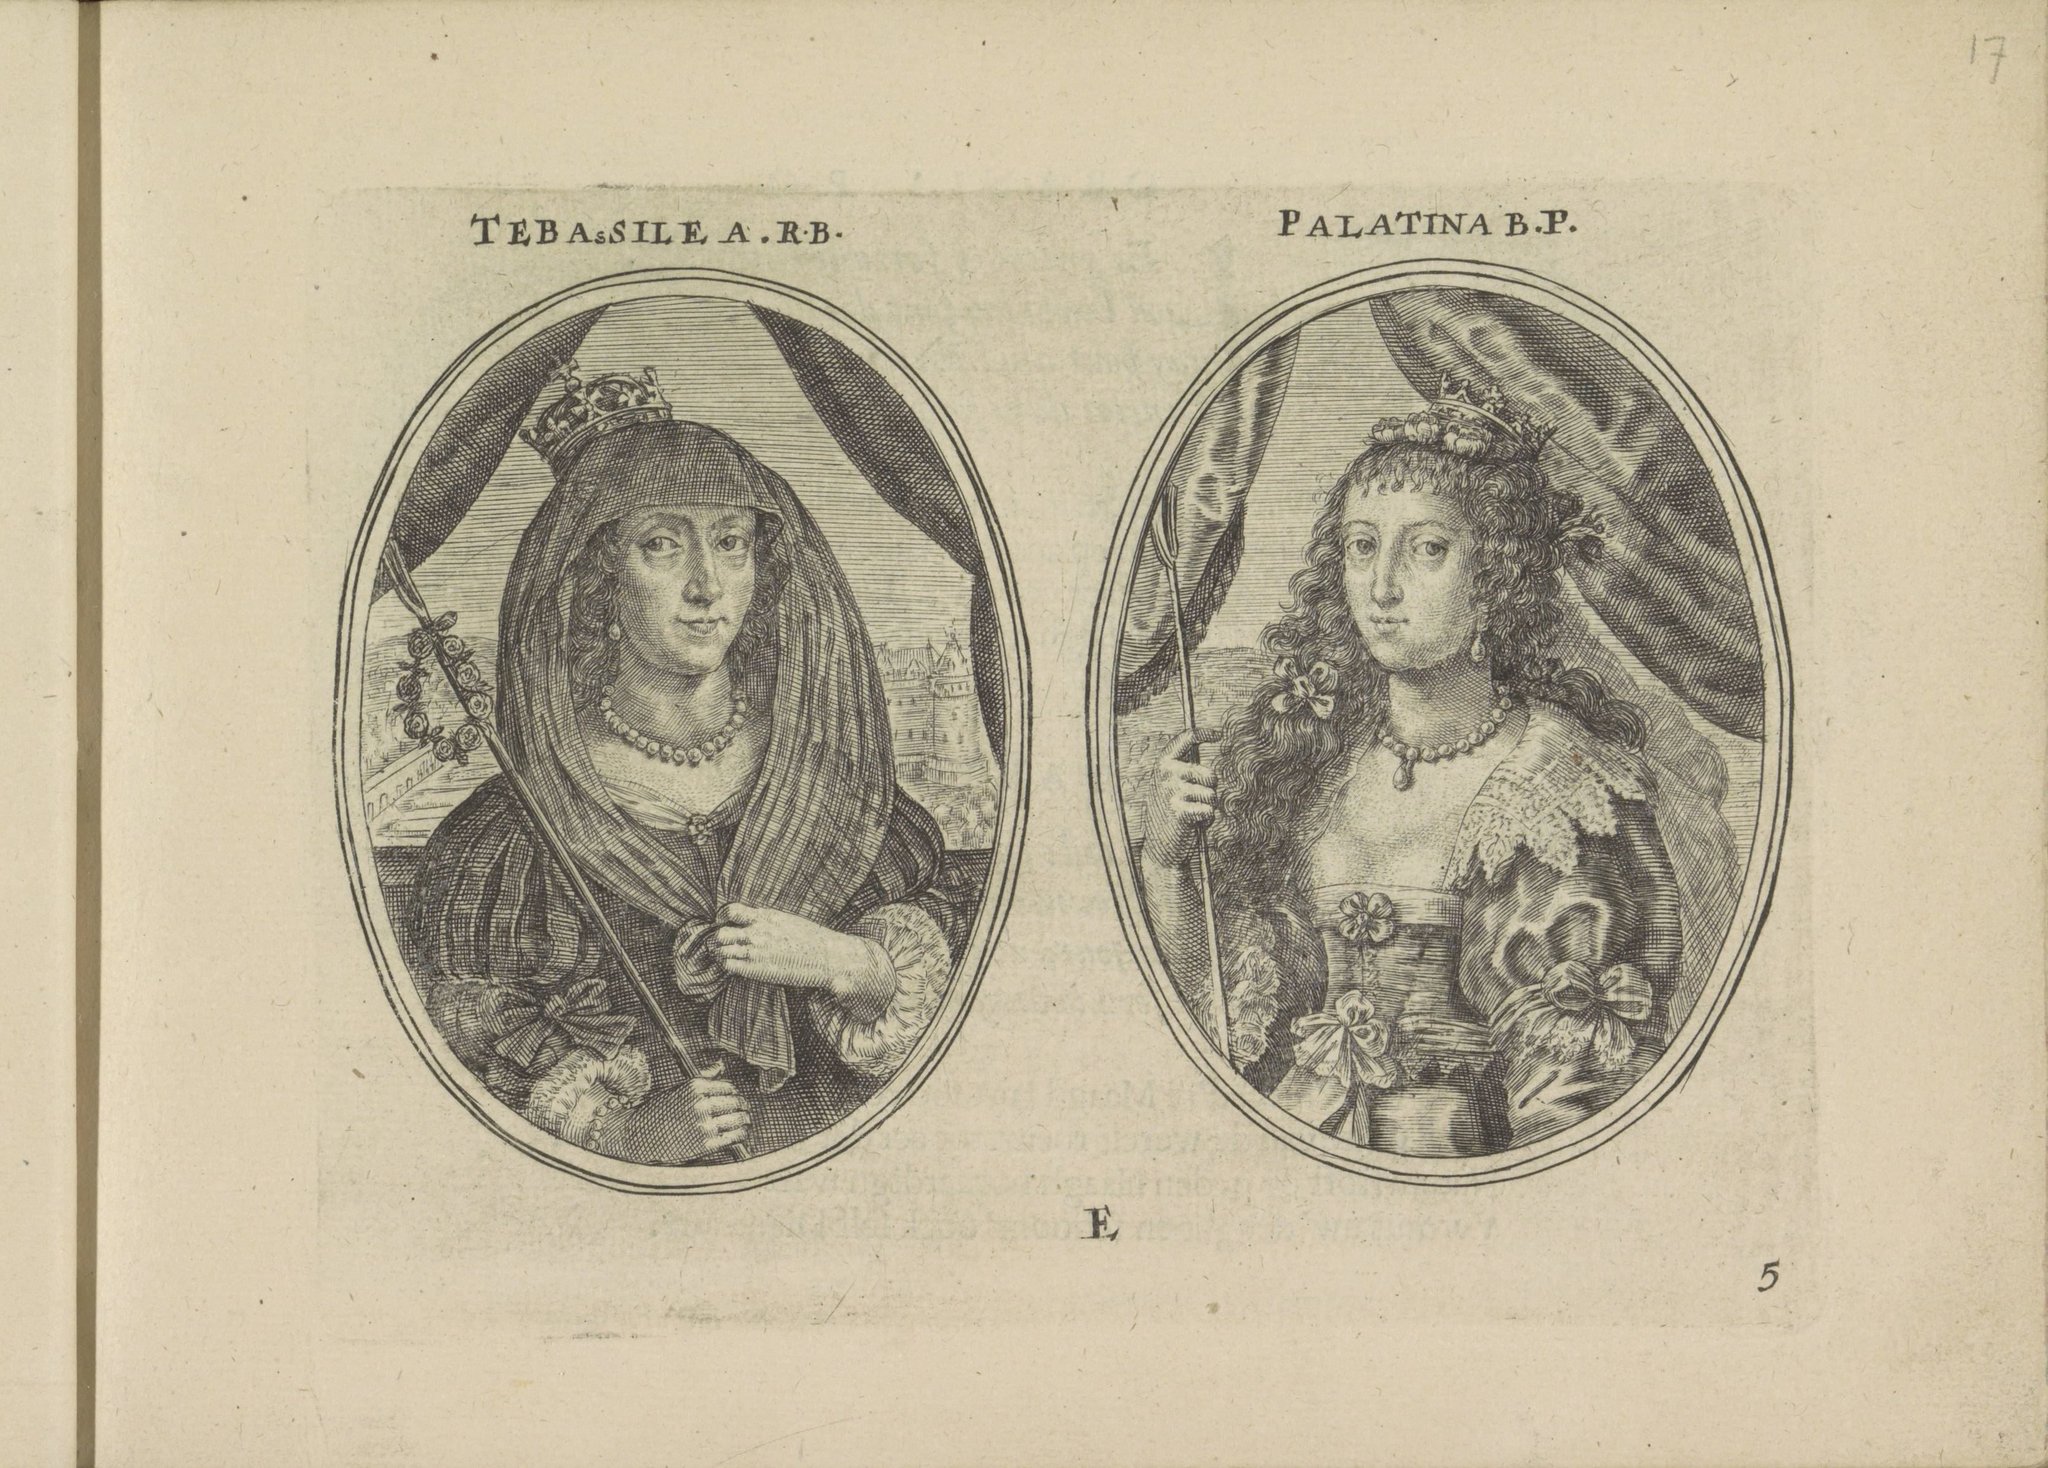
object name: album leaf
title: Tebassilea R.B. / Palatina B.P.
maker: crispijn van de passe (ii)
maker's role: draughtsman, print maker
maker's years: 1594-1670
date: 1640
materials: paper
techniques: engraving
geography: amsterdam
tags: london, female sex; woman, shepherd's crook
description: Twee voorstellingen op een albumblad. Links het portret Elisabeth Stuart van Bohemen als Tebassilea R.B. Op de achtergrond een kasteel en kasteeltuin. Rechts Louisa Juliana, hertogin van de Palts, als Palatina B.P. Beide vrouwen hebben een herdersstaf in de hand. Onderaan genummerd: E en 5. Het blad maakt deel uit van een album.